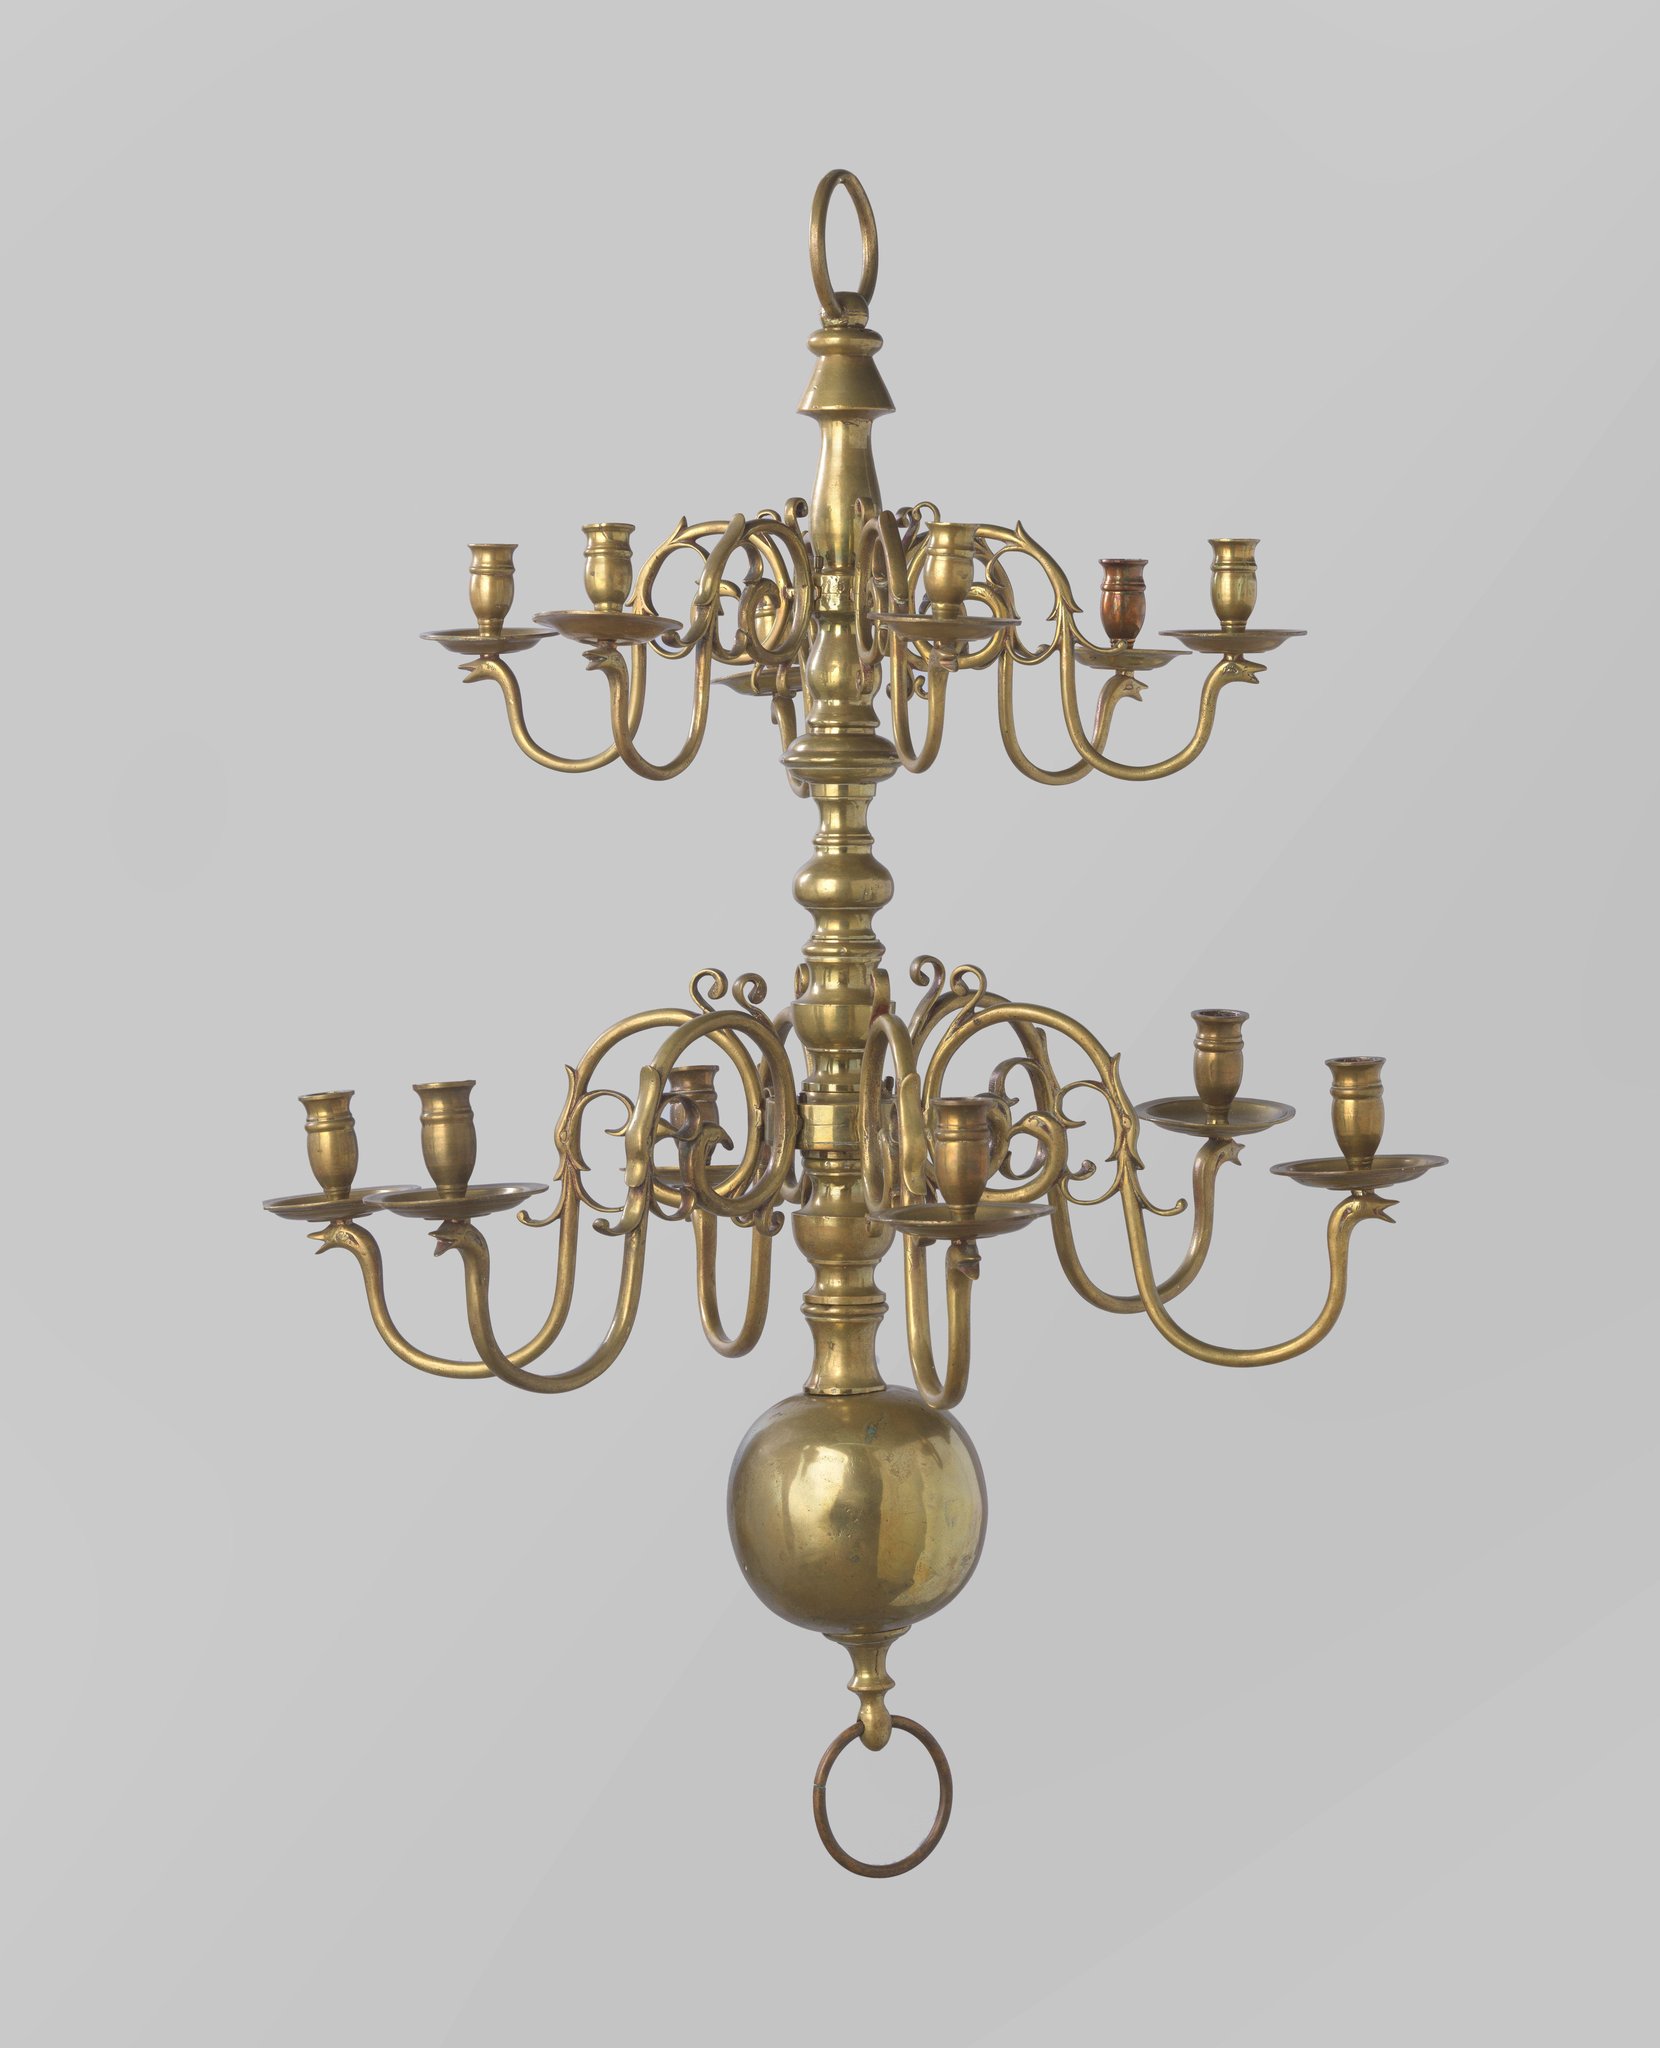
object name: chandelier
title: Arm van een kaarsenkroon in twee hoogten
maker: Anonymous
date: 1890-1910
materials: brass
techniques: casting, screwed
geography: netherlands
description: De arm heeft een S-vorm, naar buiten toe eindigend in een slangenkop en op het andere eind in vogelkop. De arm is aldaar met krullen versierd. Er is schroefdraden aangebracht in het uitsteeksel aan de kaarsenhouder, de arm of op het einde van de verbindingsstang. Dit is de vijfde arm van de bovenste standring, genummerd met het cijfer 5.